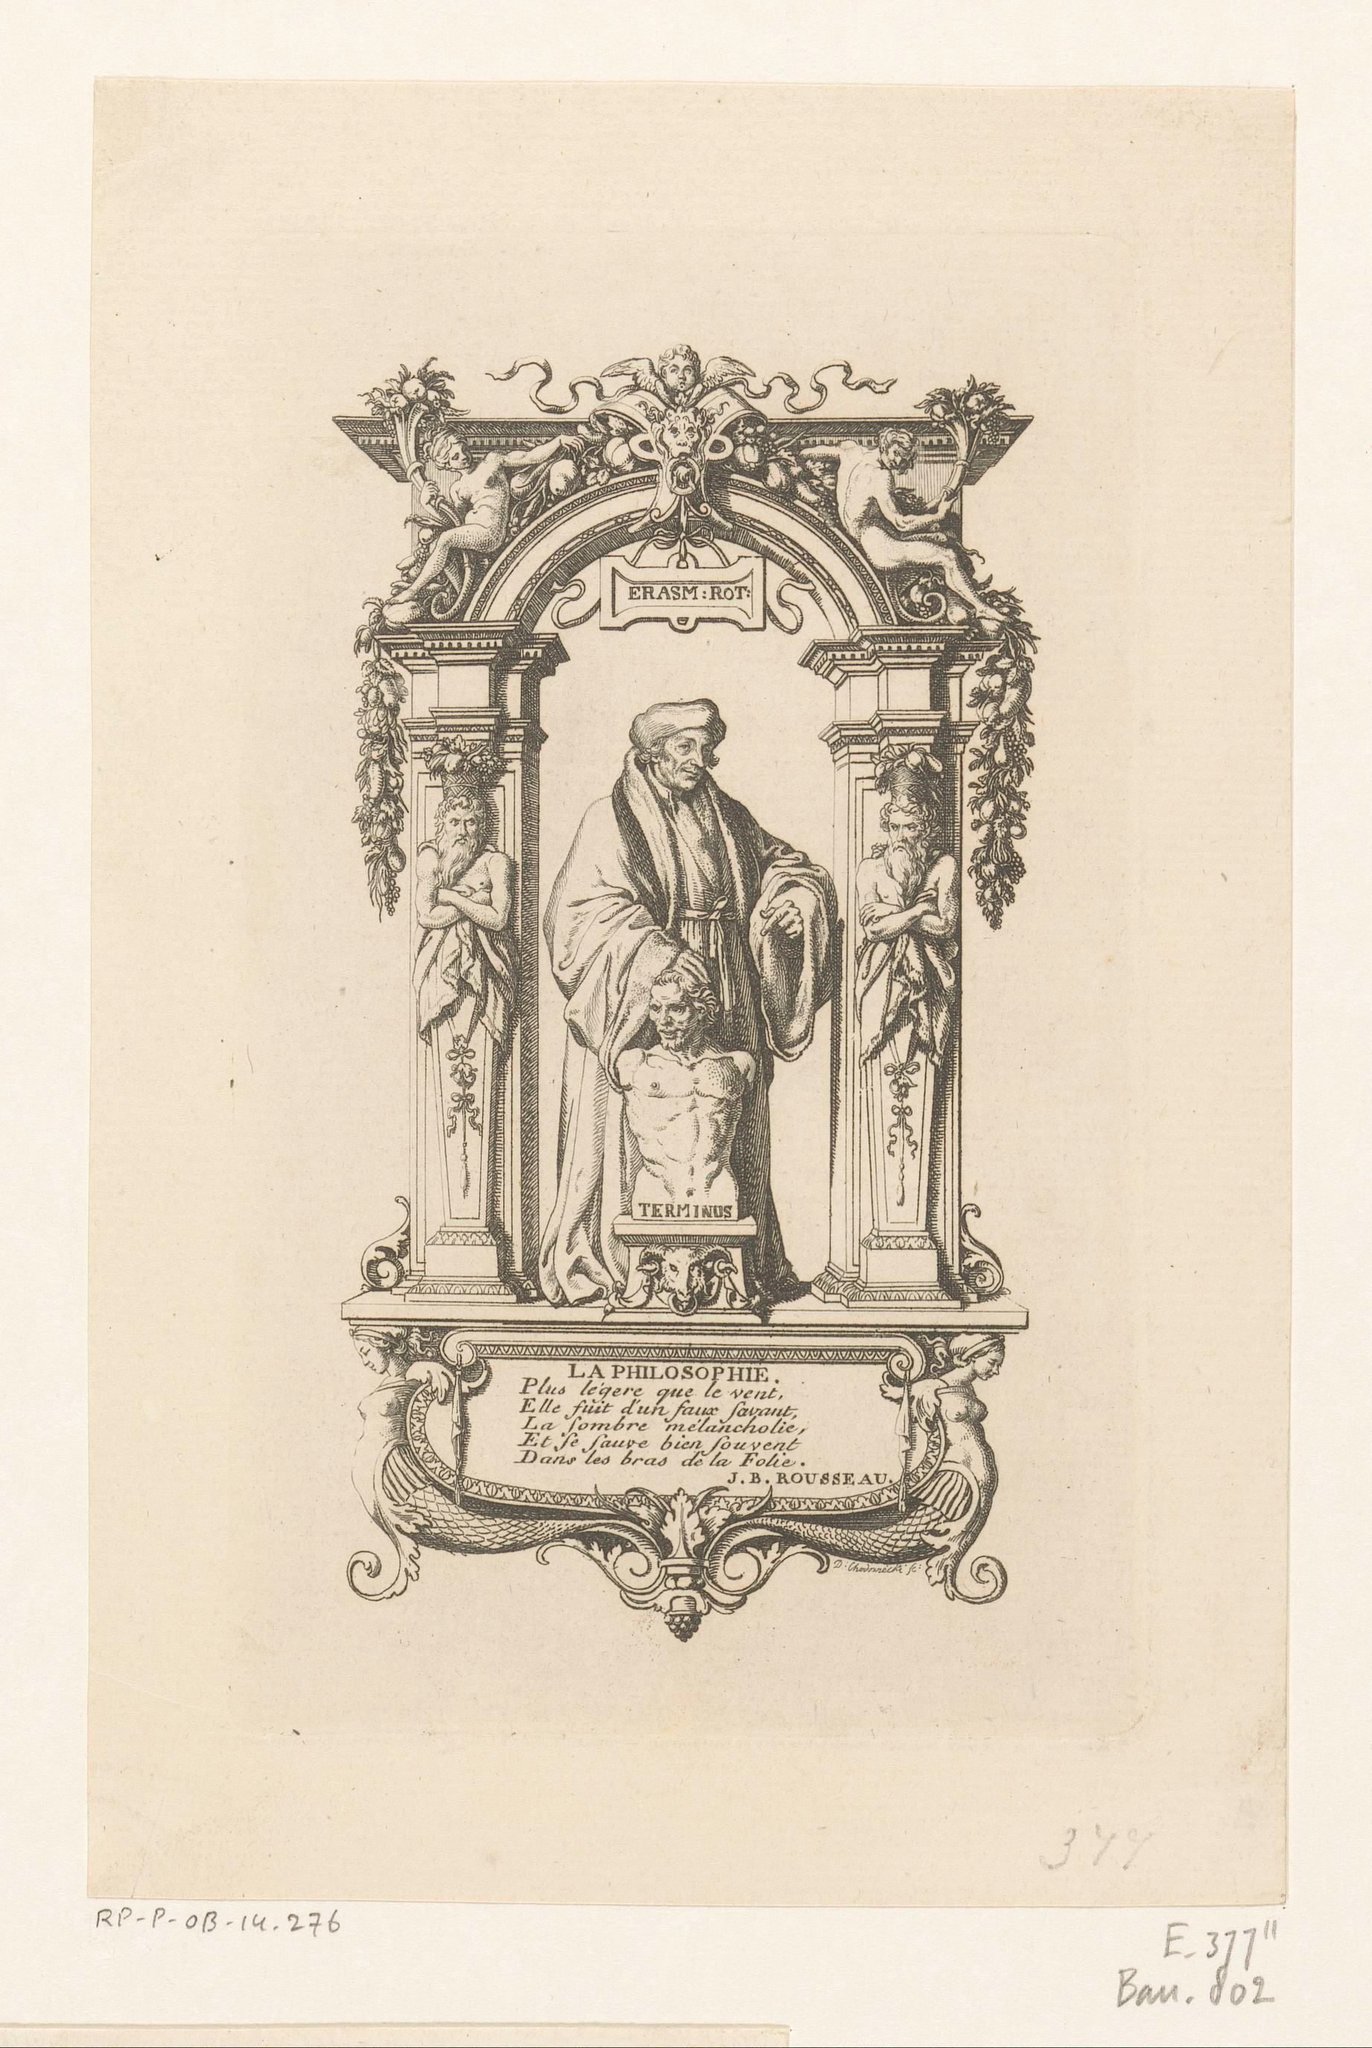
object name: print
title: Beeld van Erasmus in architecturale omlijsting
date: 1780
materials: paper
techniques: etching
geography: gdansk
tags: rotterdam, desiderius erasmus, cherubs, i.e. children's heads with wings, 'cornucopia', horn of plenty, herms (garden ornaments), merman - aa - mermaid, siren, terminus, ornament ~ cartouche, sculpture, ornament ~ festoon, garland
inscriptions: collector's mark: Lugt 2228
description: Prent gebruikt voor: Erasmus, Desiderius. Das Lob der Narrheit aus dem Lateinischen des Erasmus. Mit Kupfern von Chodowiecky. Berlijn en Leipzig: Georg Jacob Decker, 1781.